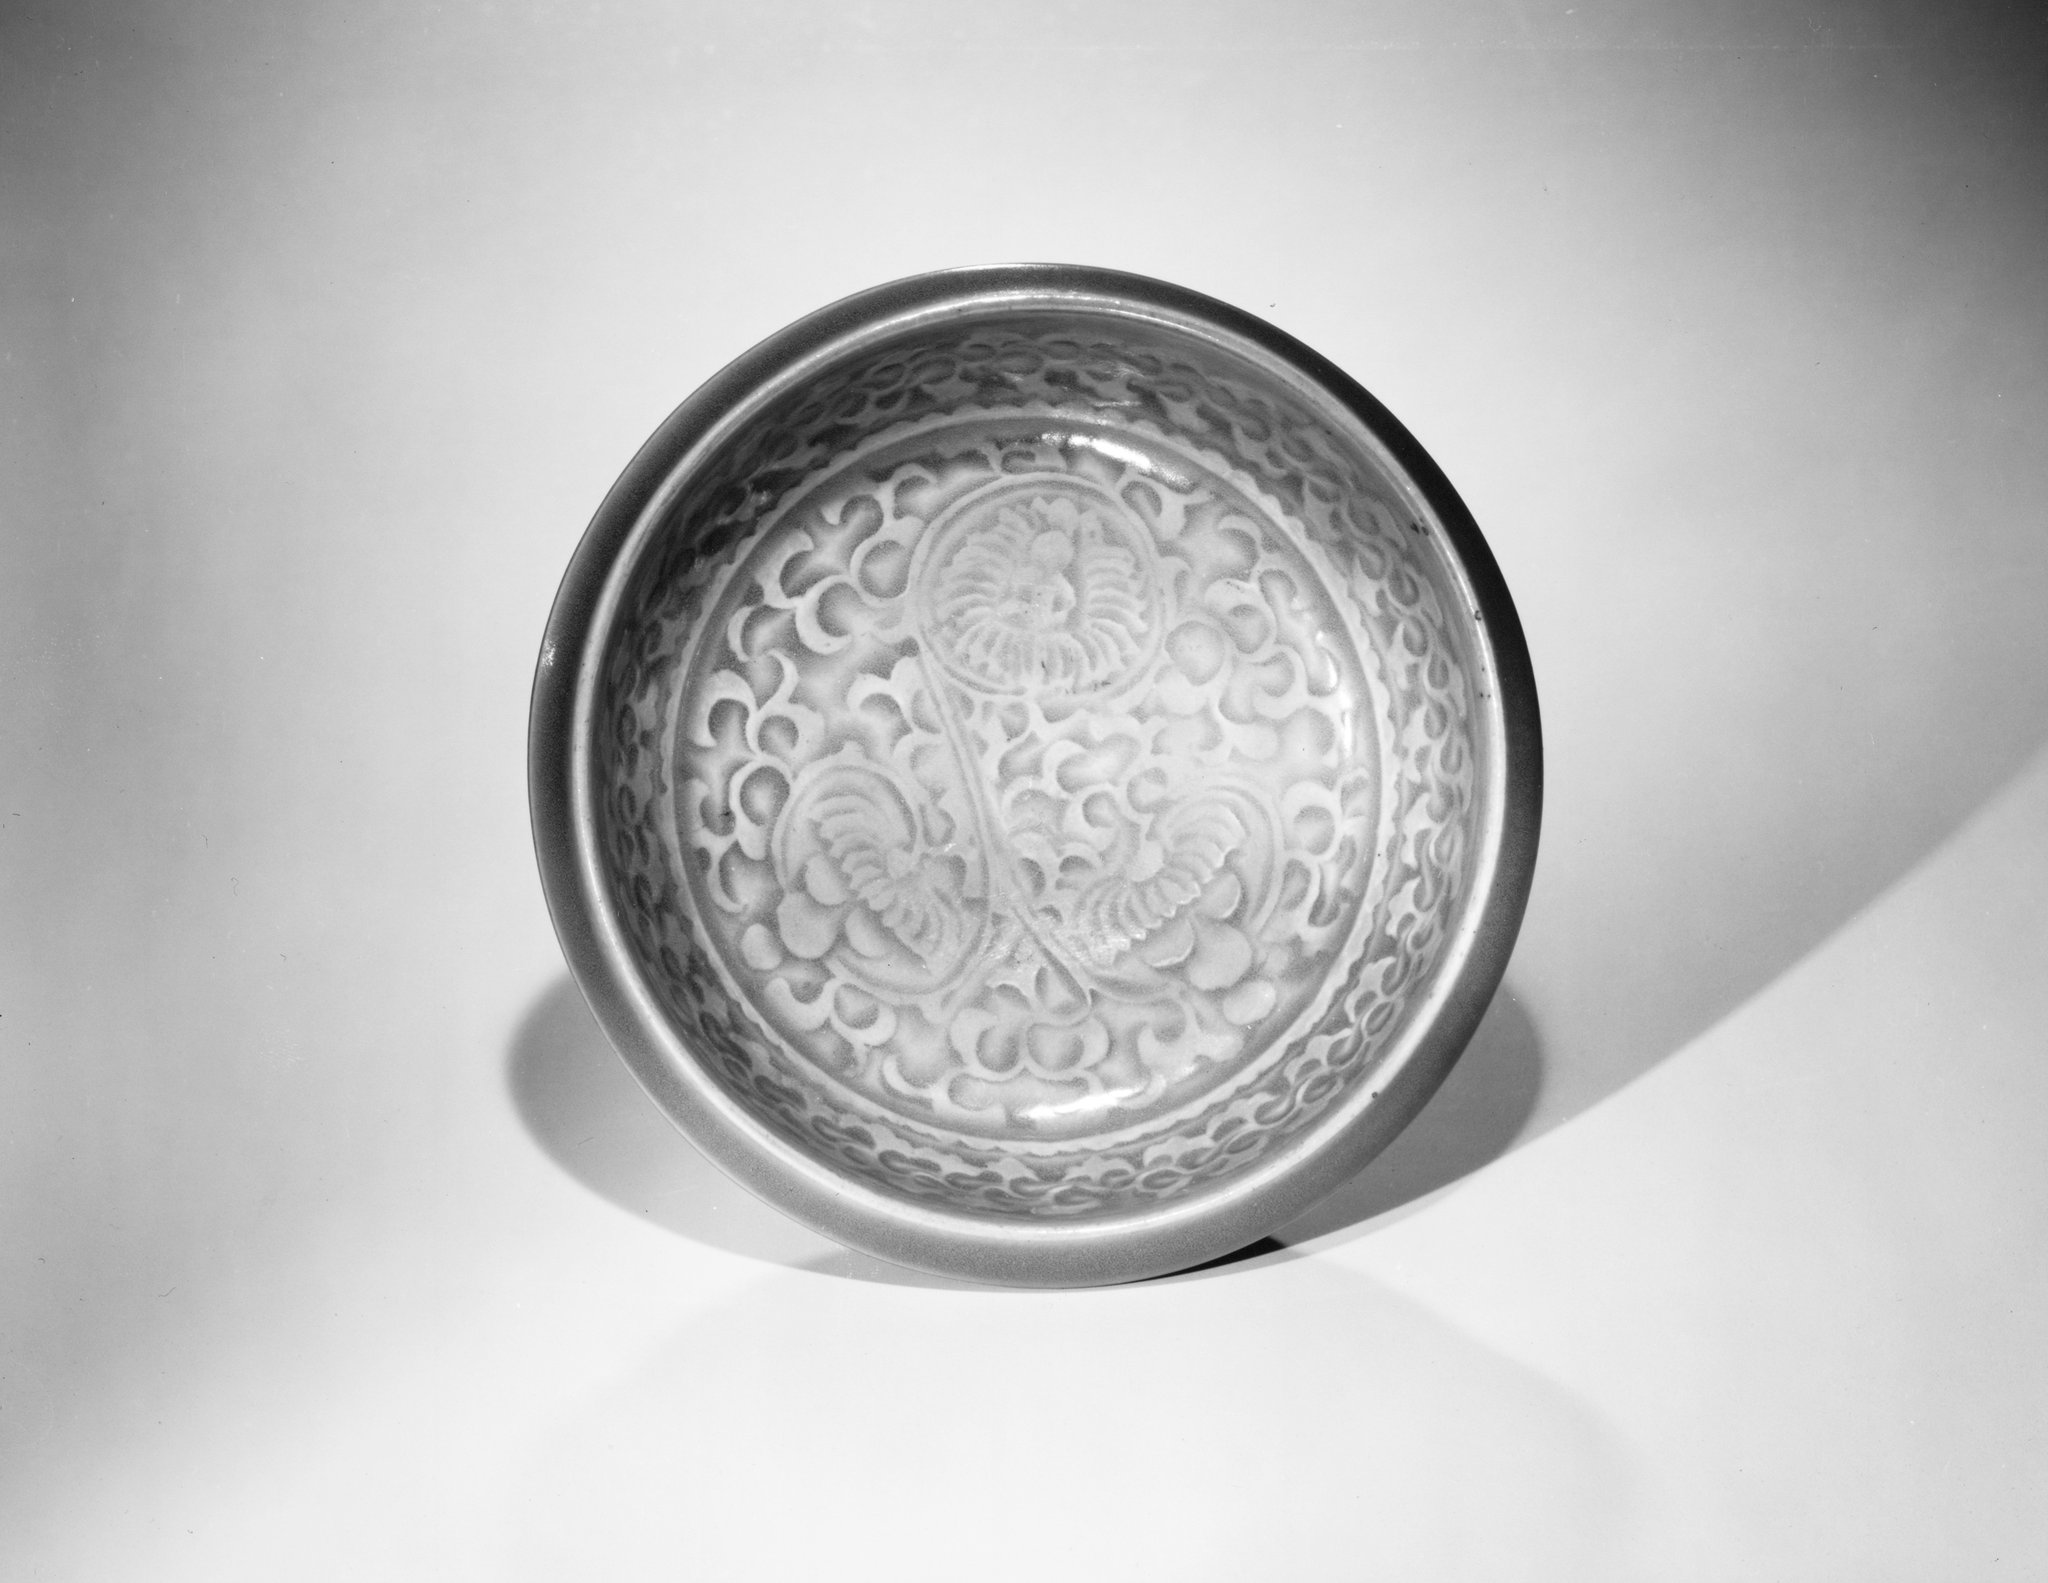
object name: dish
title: Small Dish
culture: chinese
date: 1001-1200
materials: ceramic glaze, glaze, stoneware